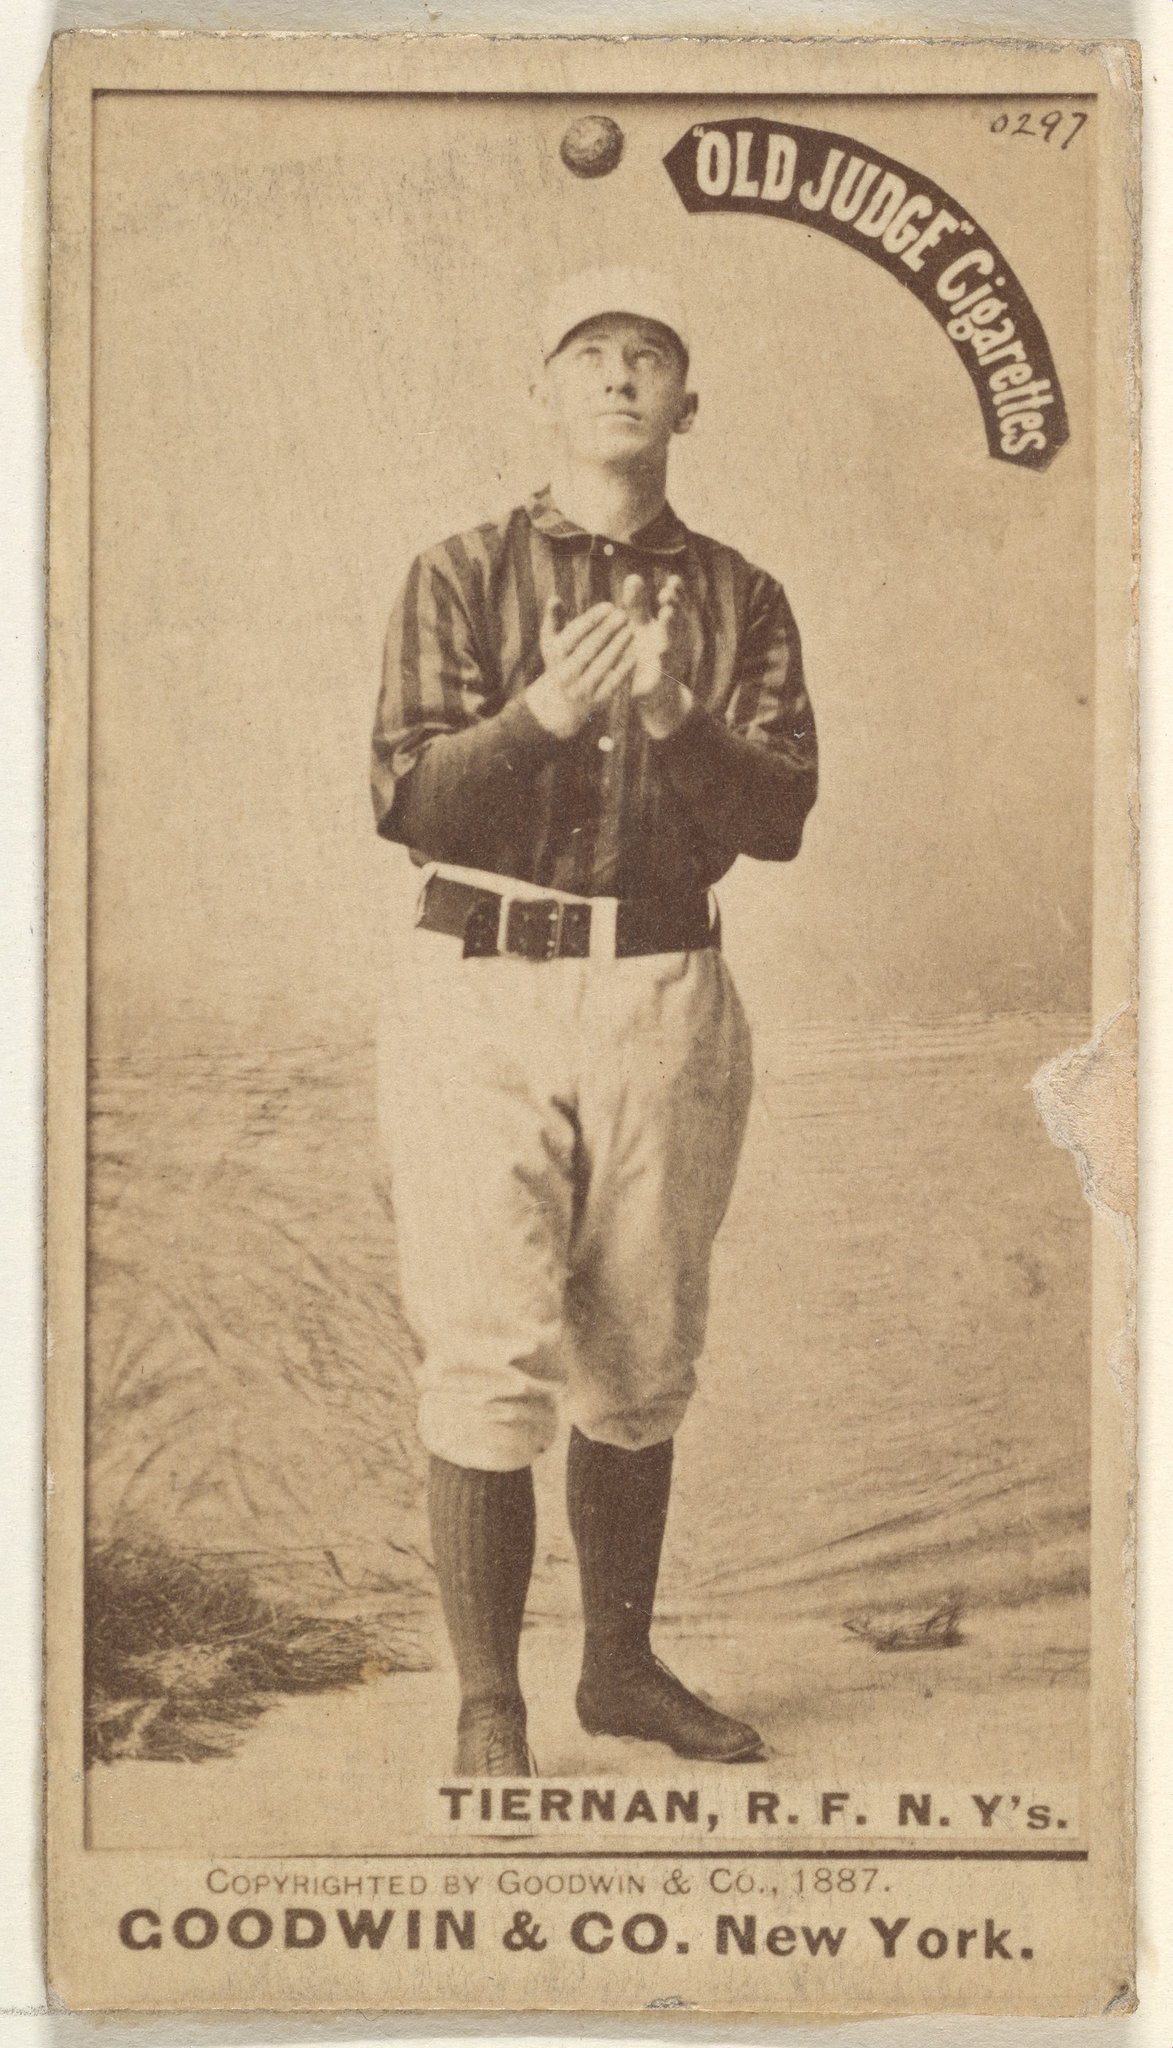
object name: baseball card, photograph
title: Michael "Silent Mike" Joseph Tiernan, Right Field, New York, from the Old Judge series (N172) for Old Judge Cigarettes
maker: goodwin & company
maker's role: publisher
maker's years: 1850-1950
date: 1887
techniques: albumen silver print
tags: men,portraits,baseball,athletes